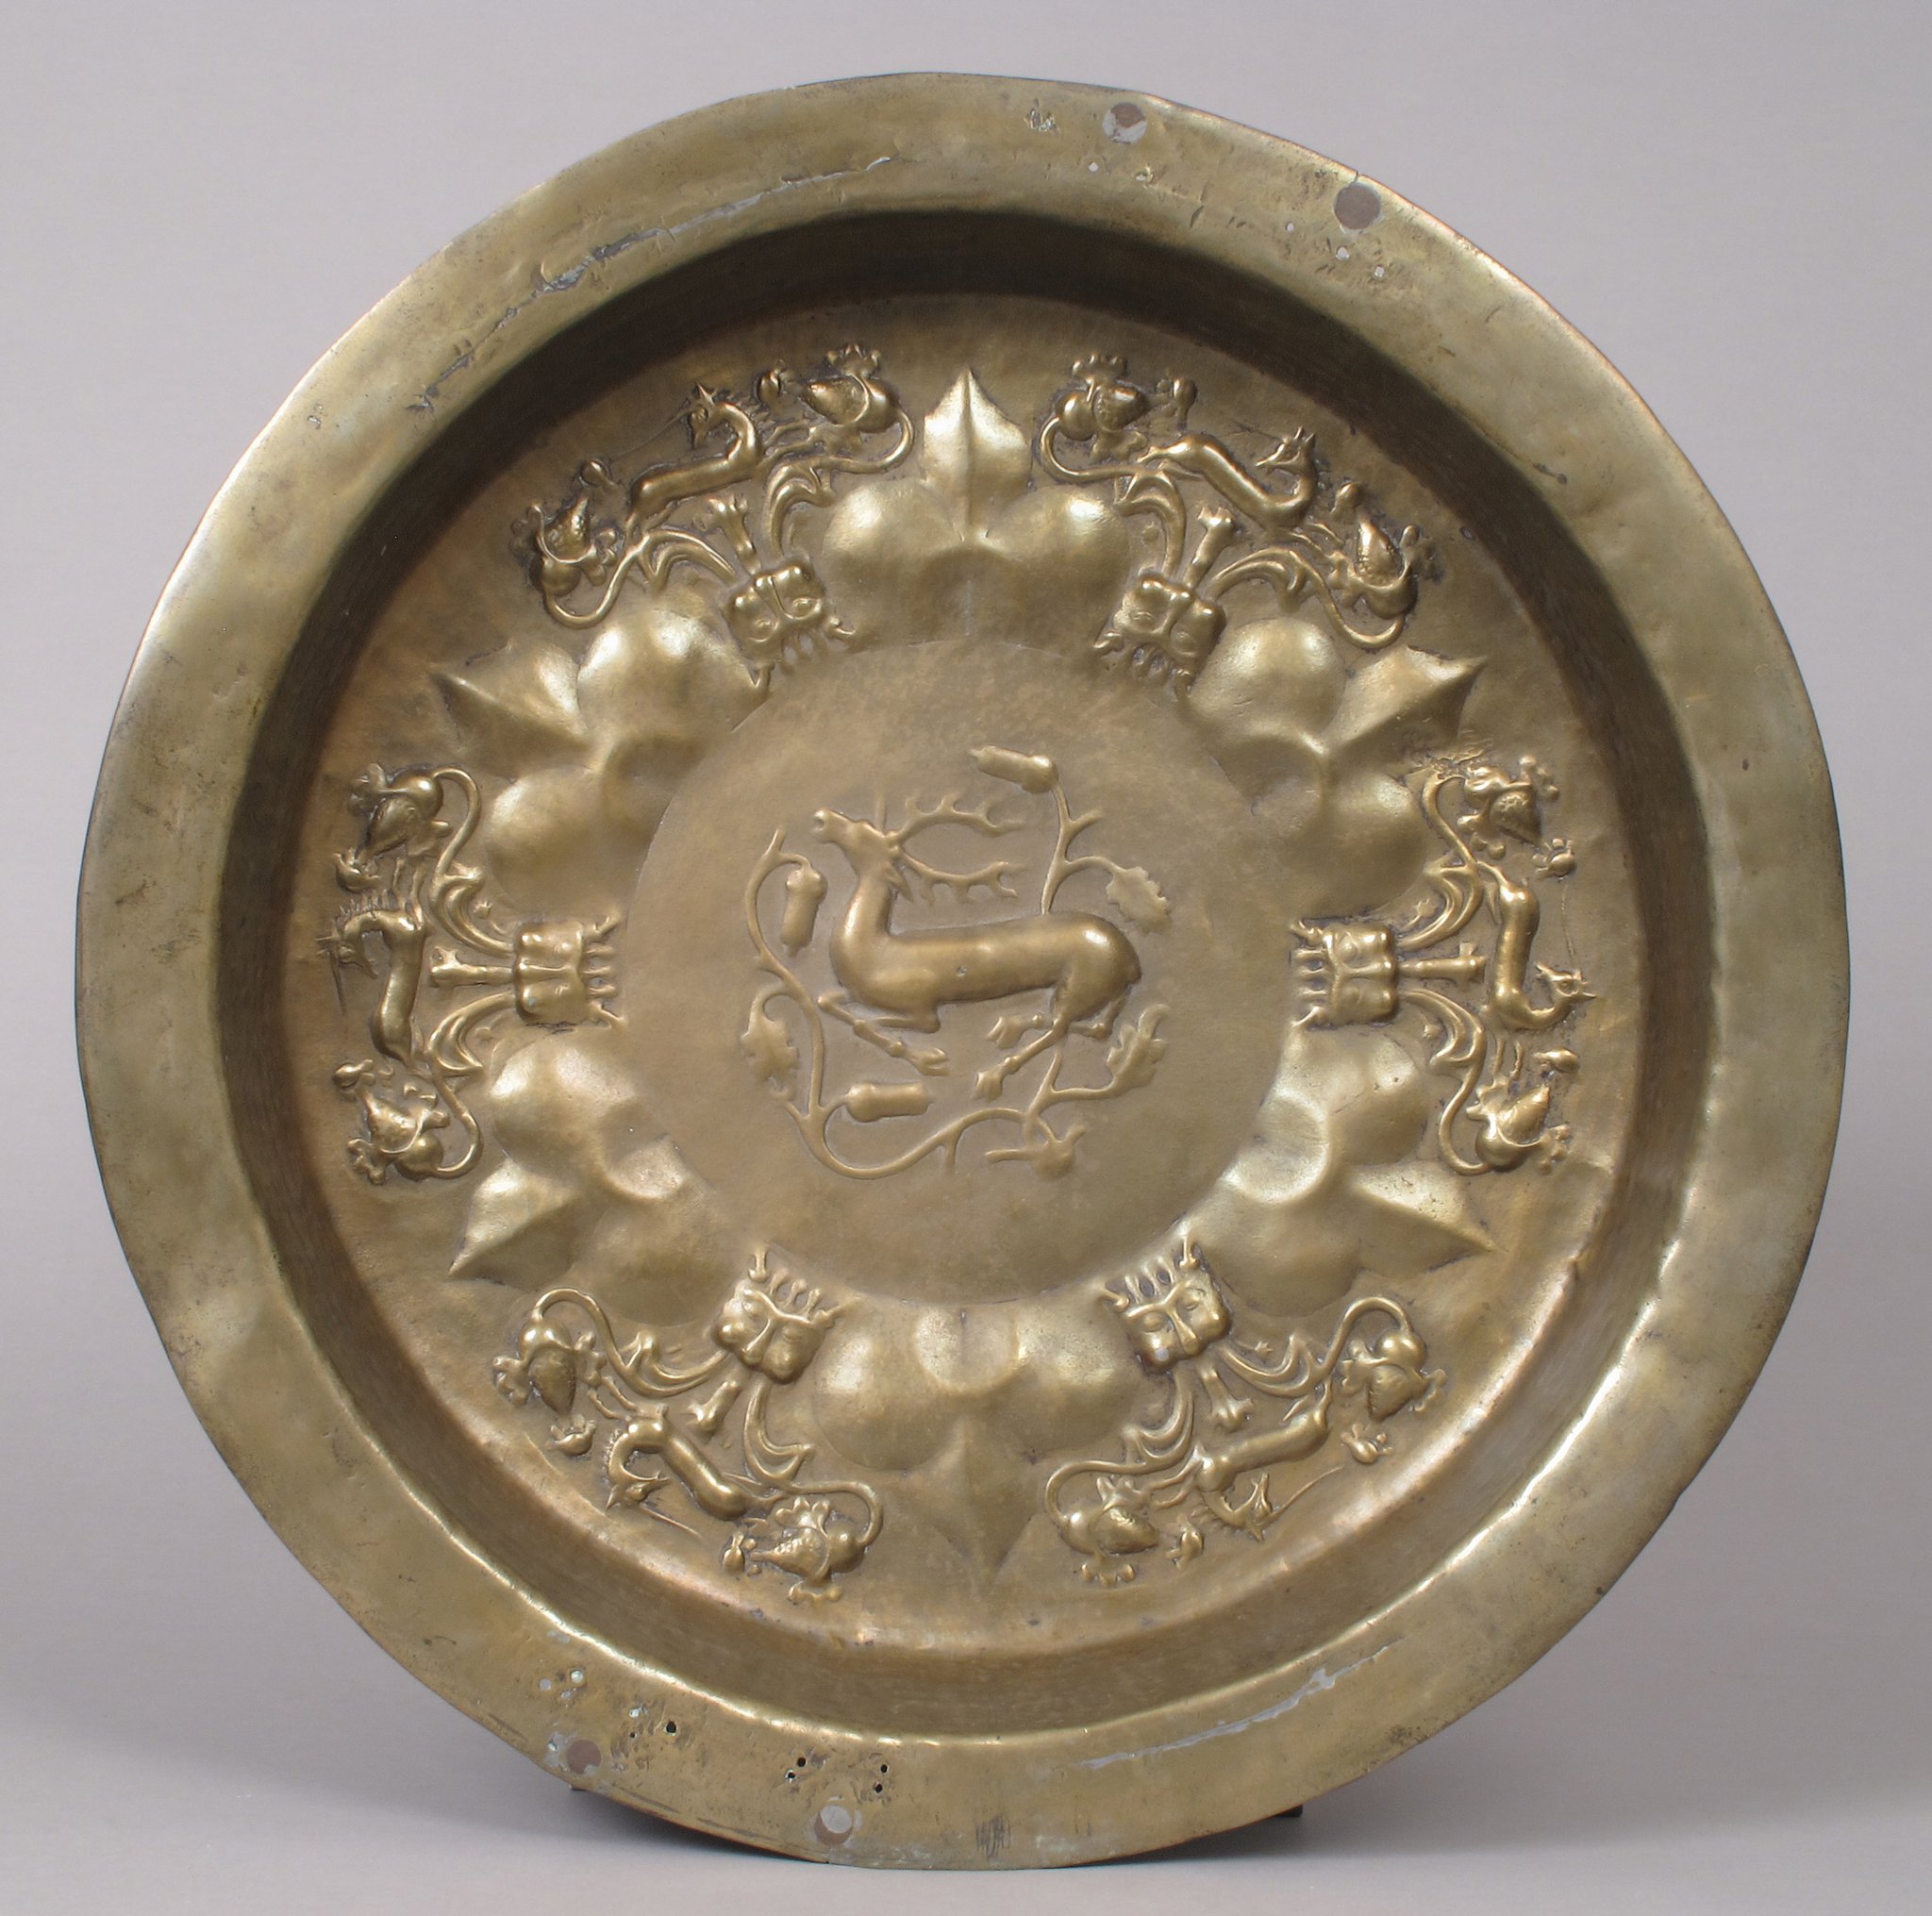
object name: plate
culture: german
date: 1467-1500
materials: brass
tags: deer